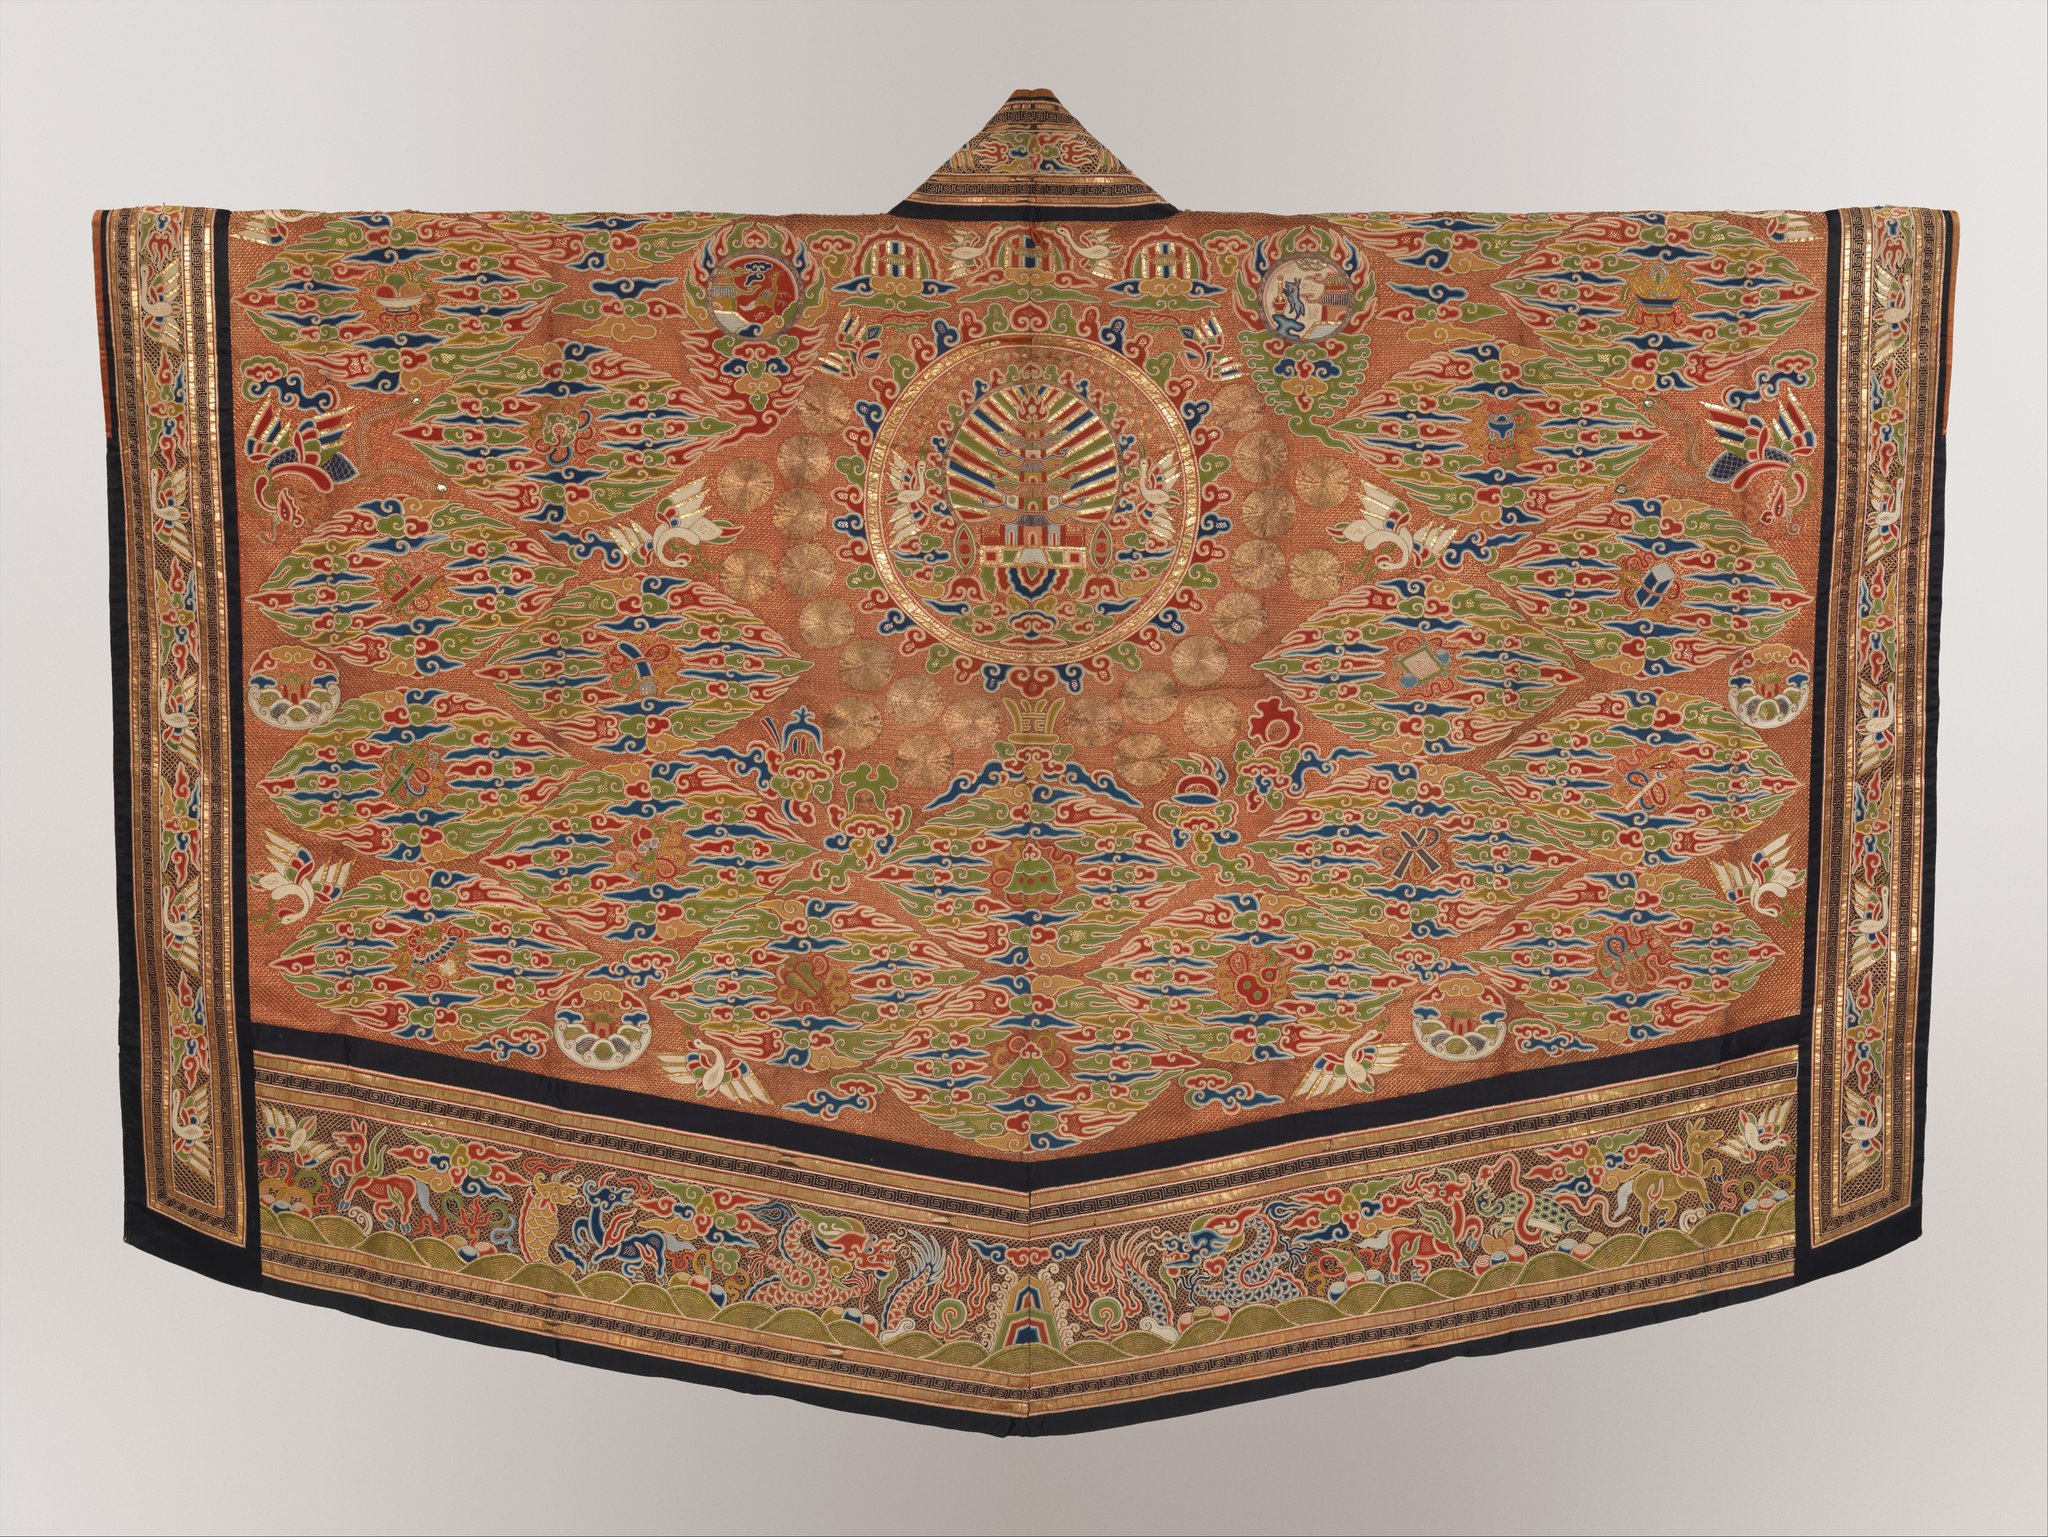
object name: robe, daoist priest's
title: Daoist priest’s robe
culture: chinese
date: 1701-1800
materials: metal thread, textile, silk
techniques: embroidery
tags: cranes,dragons